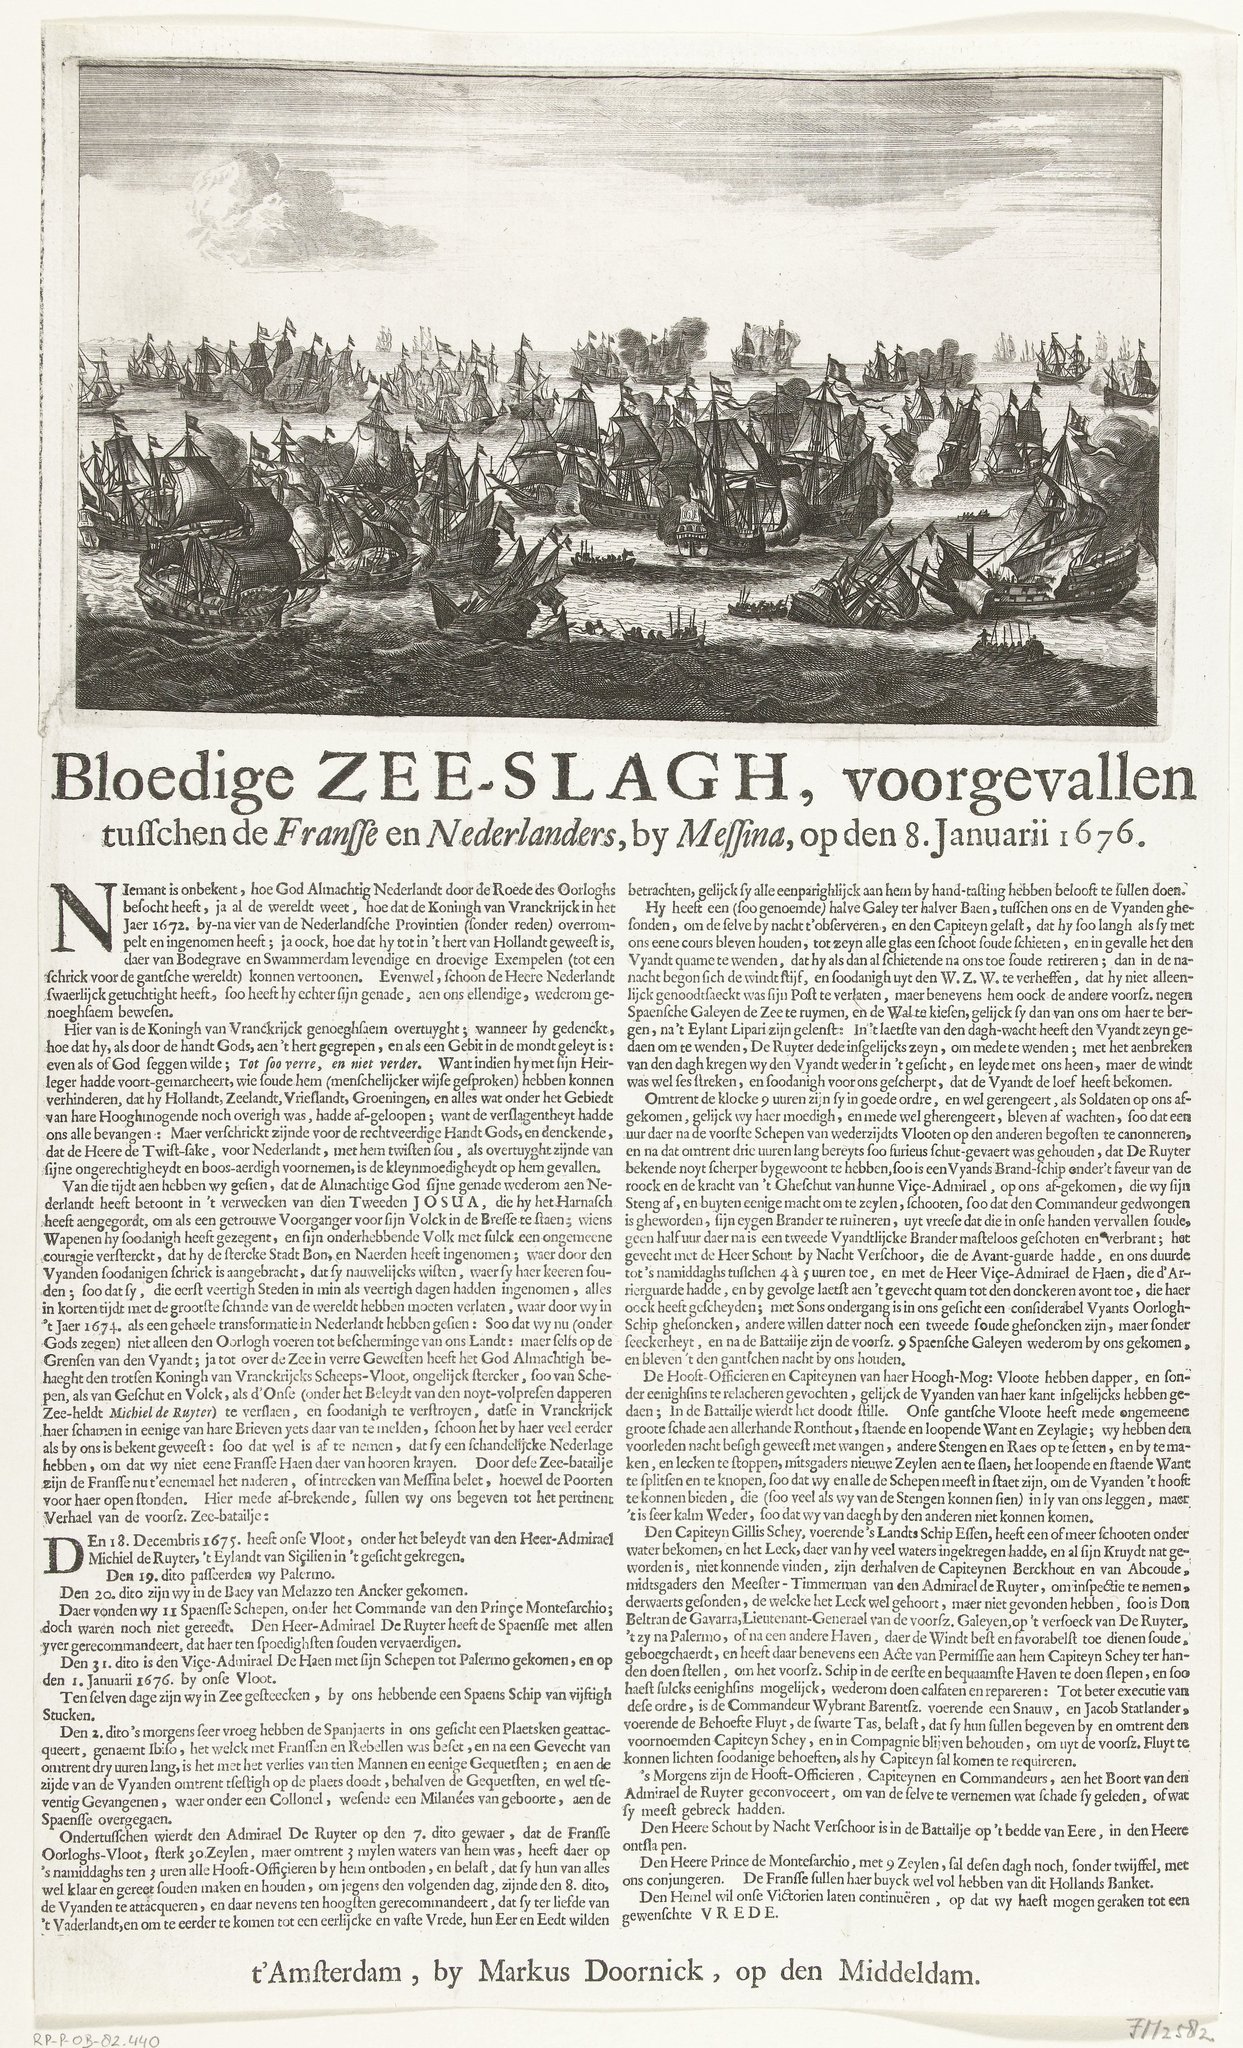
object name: print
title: Zeeslag bij Stromboli, 1676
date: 1676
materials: paper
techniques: engraving, etching, letterpress printing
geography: amsterdam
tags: flushing, michiel adriaenszoon de ruyter, paris, battle (+ naval force), battle of stromboli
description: Zeeslag bij Stromboli op 8 januari 1676 tussen de vloot van de Republiek onder Michiel Adriaenszoon de Ruyter en een Franse vloot onder Abraham Duquesne. Gedrukt onder de plaat een tekst in 2 kolommen in het Nederlands.